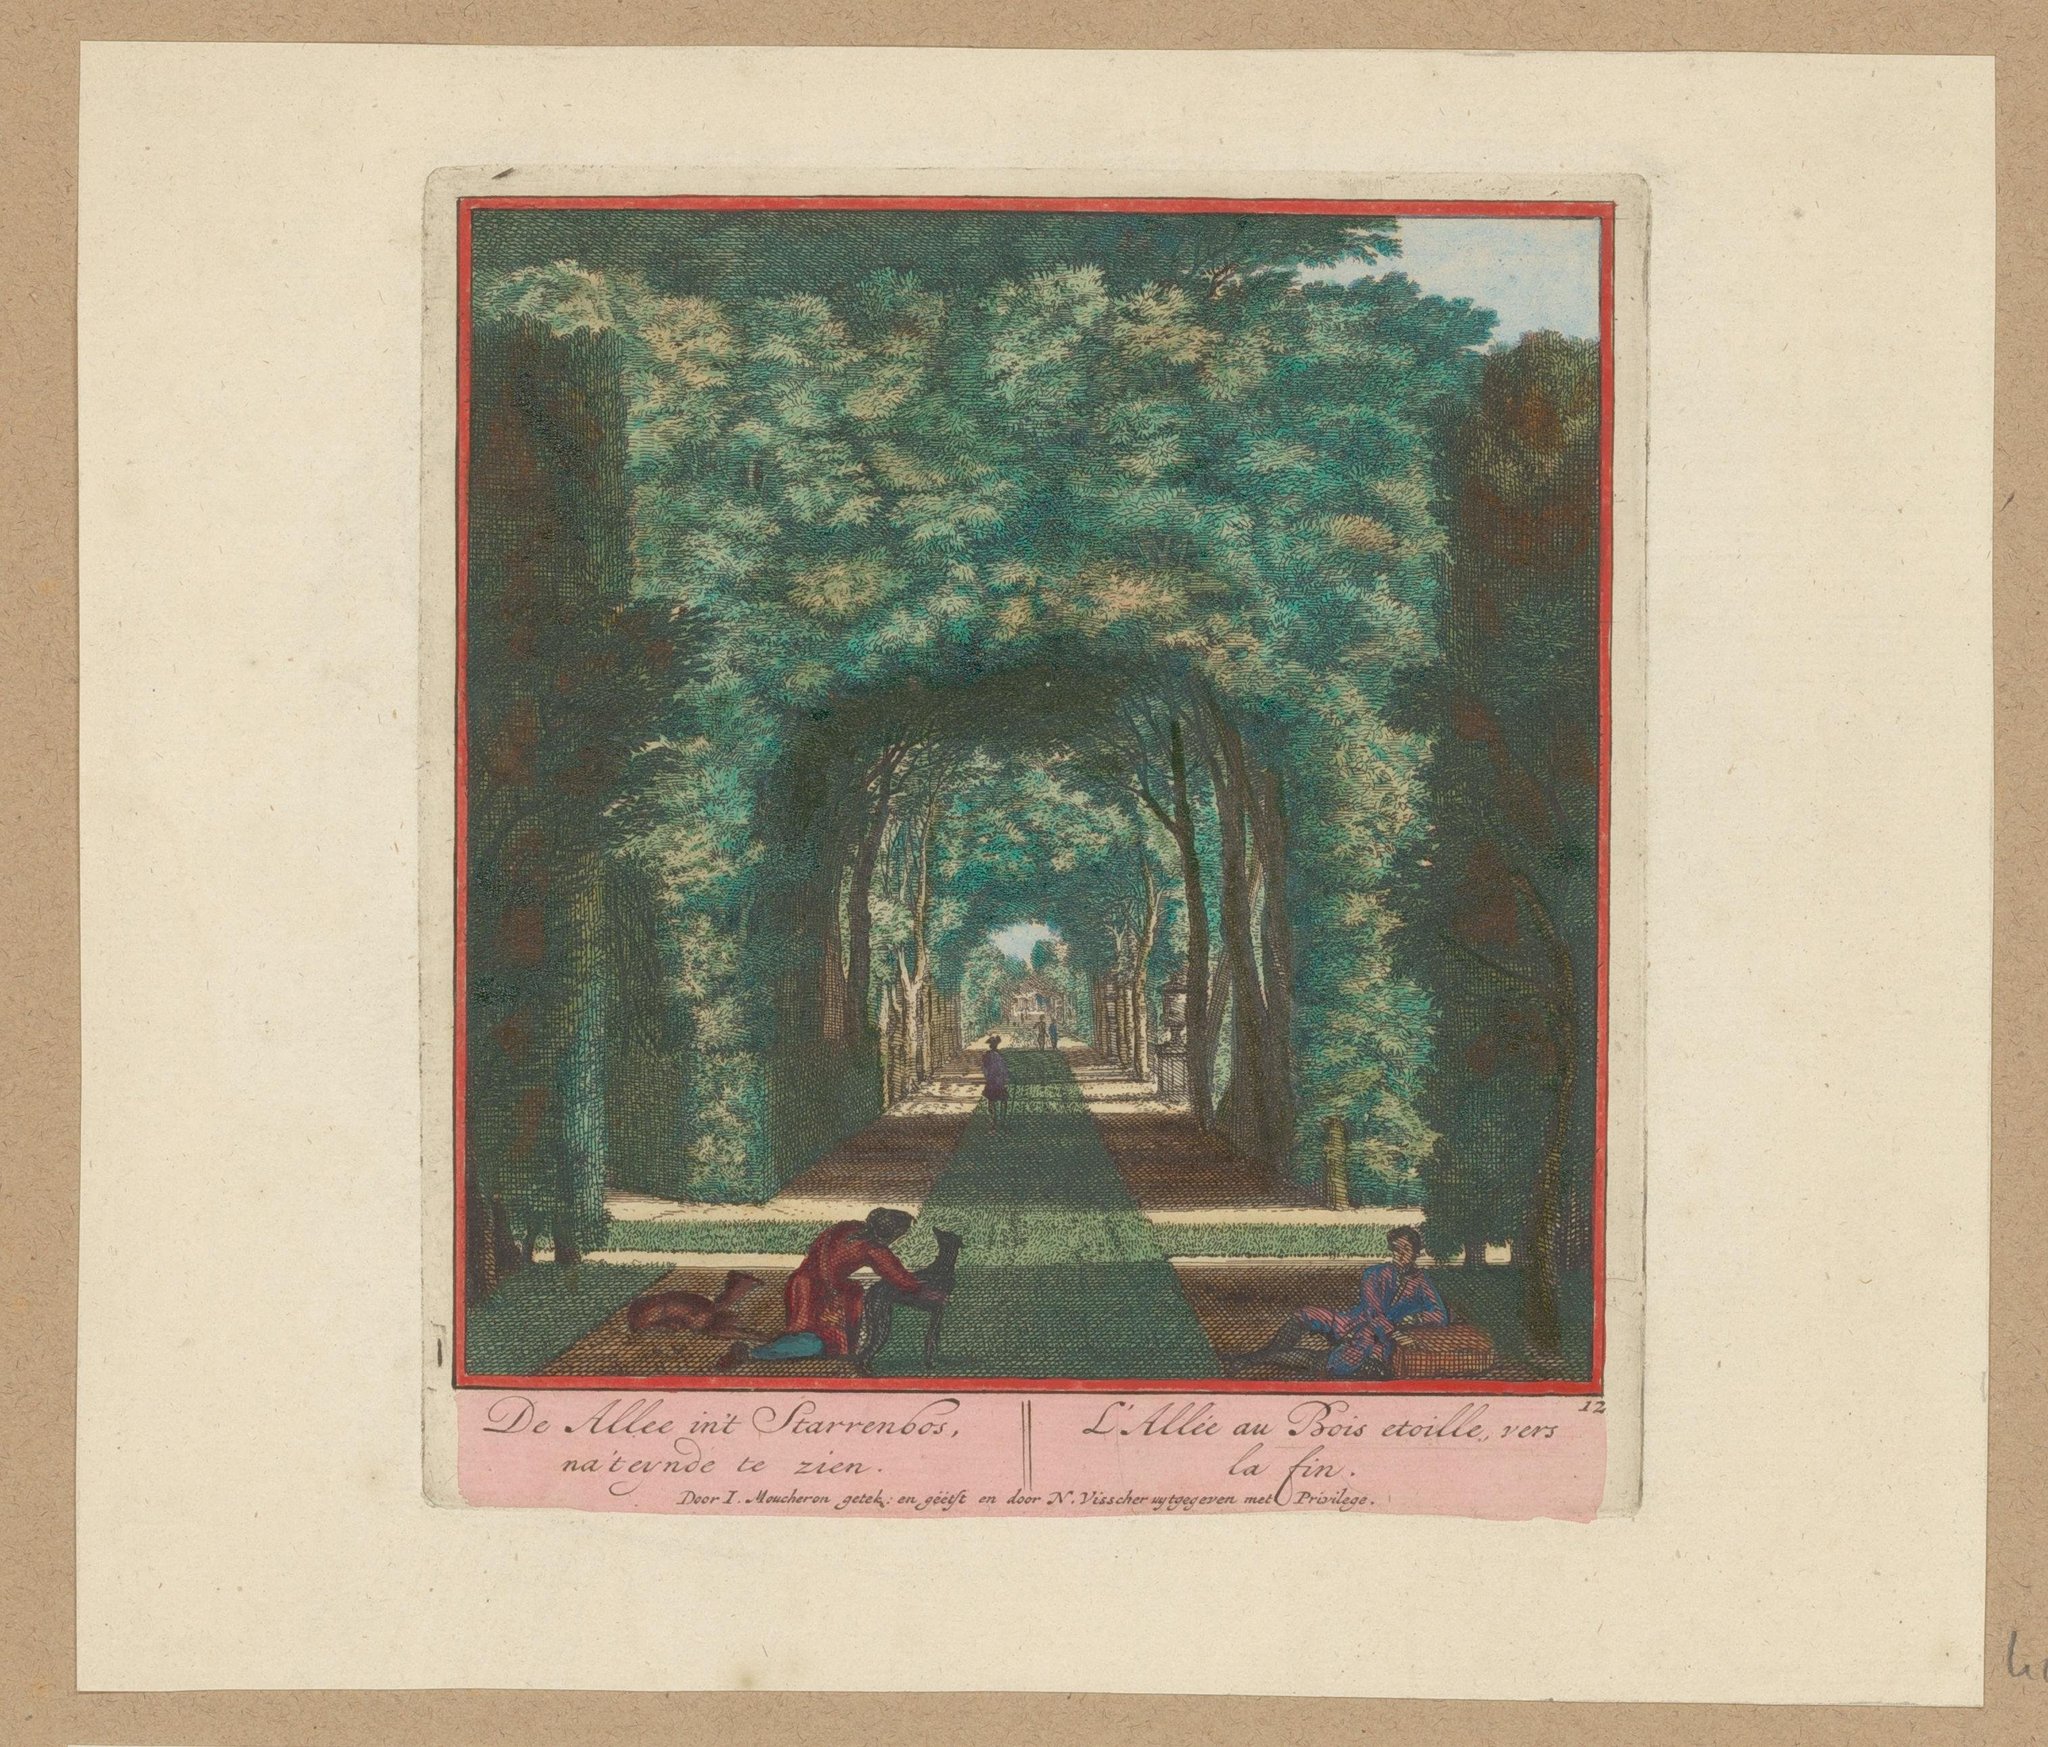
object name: print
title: Gezichten op Kasteel Heemstede in de provincie Utrecht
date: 1706-1719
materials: paper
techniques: engraving, etching, hand coloring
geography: amsterdam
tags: pergola, dog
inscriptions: stamp, collector's mark: Lugt 1641, stamp, stamp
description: Door bomen overdekt pad op het landgoed van Kasteel Heemstede. Rechtsonder genummerd: 12. Onderwerpsrubrieken binnen de Atlas Zeden en Gewoonten: Zeden en Gewoonten in Engeren Zin, De Woning, Oude Nederlandsche Tuinkunst, De 17de en 18de eeuw. Stadtuinen.